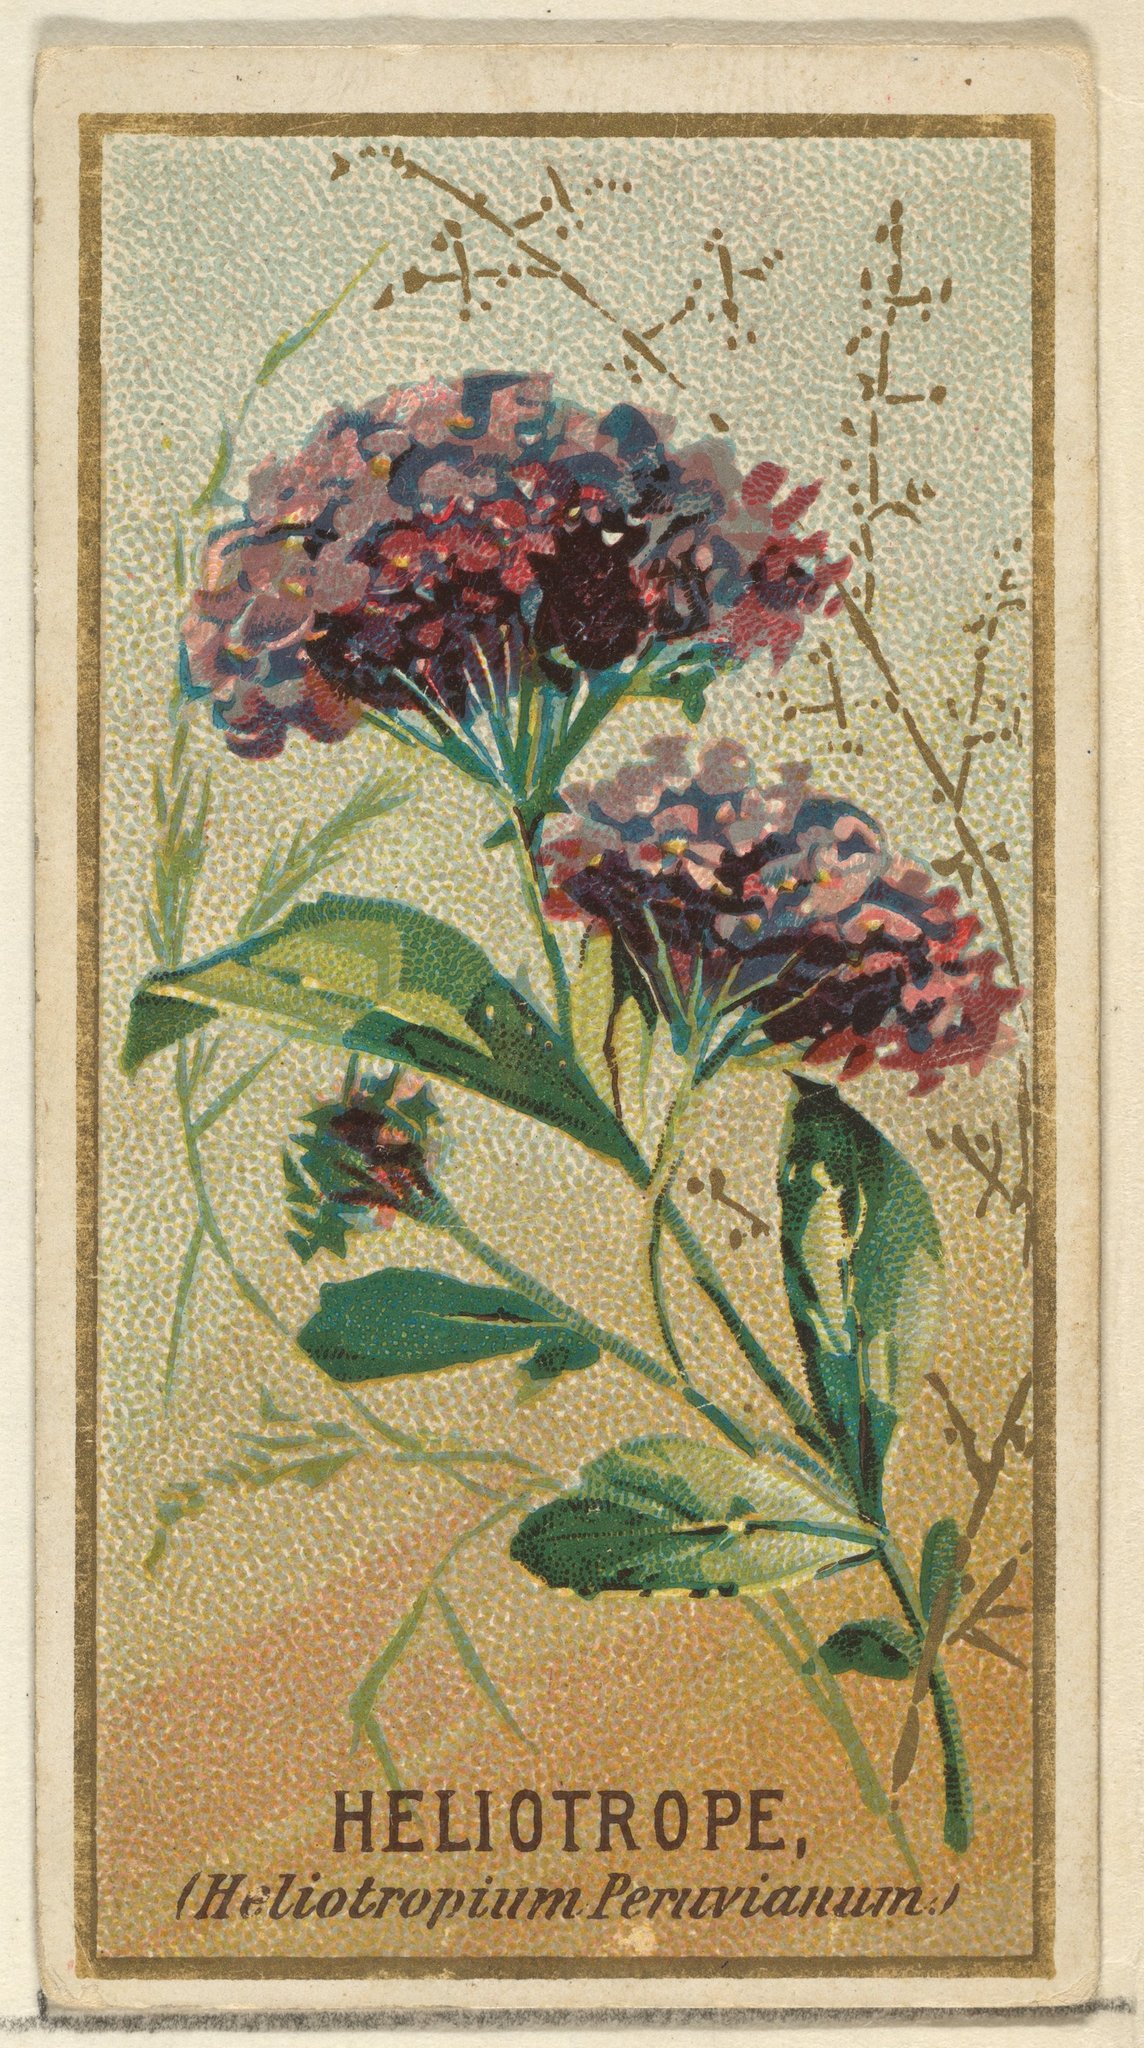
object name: print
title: Heliotrope (Heliotropium Peruvianum), from the Flowers series for Old Judge Cigarettes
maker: goodwin & company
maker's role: publisher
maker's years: 1850-1950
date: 1890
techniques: color lithograph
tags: flowers,leaves